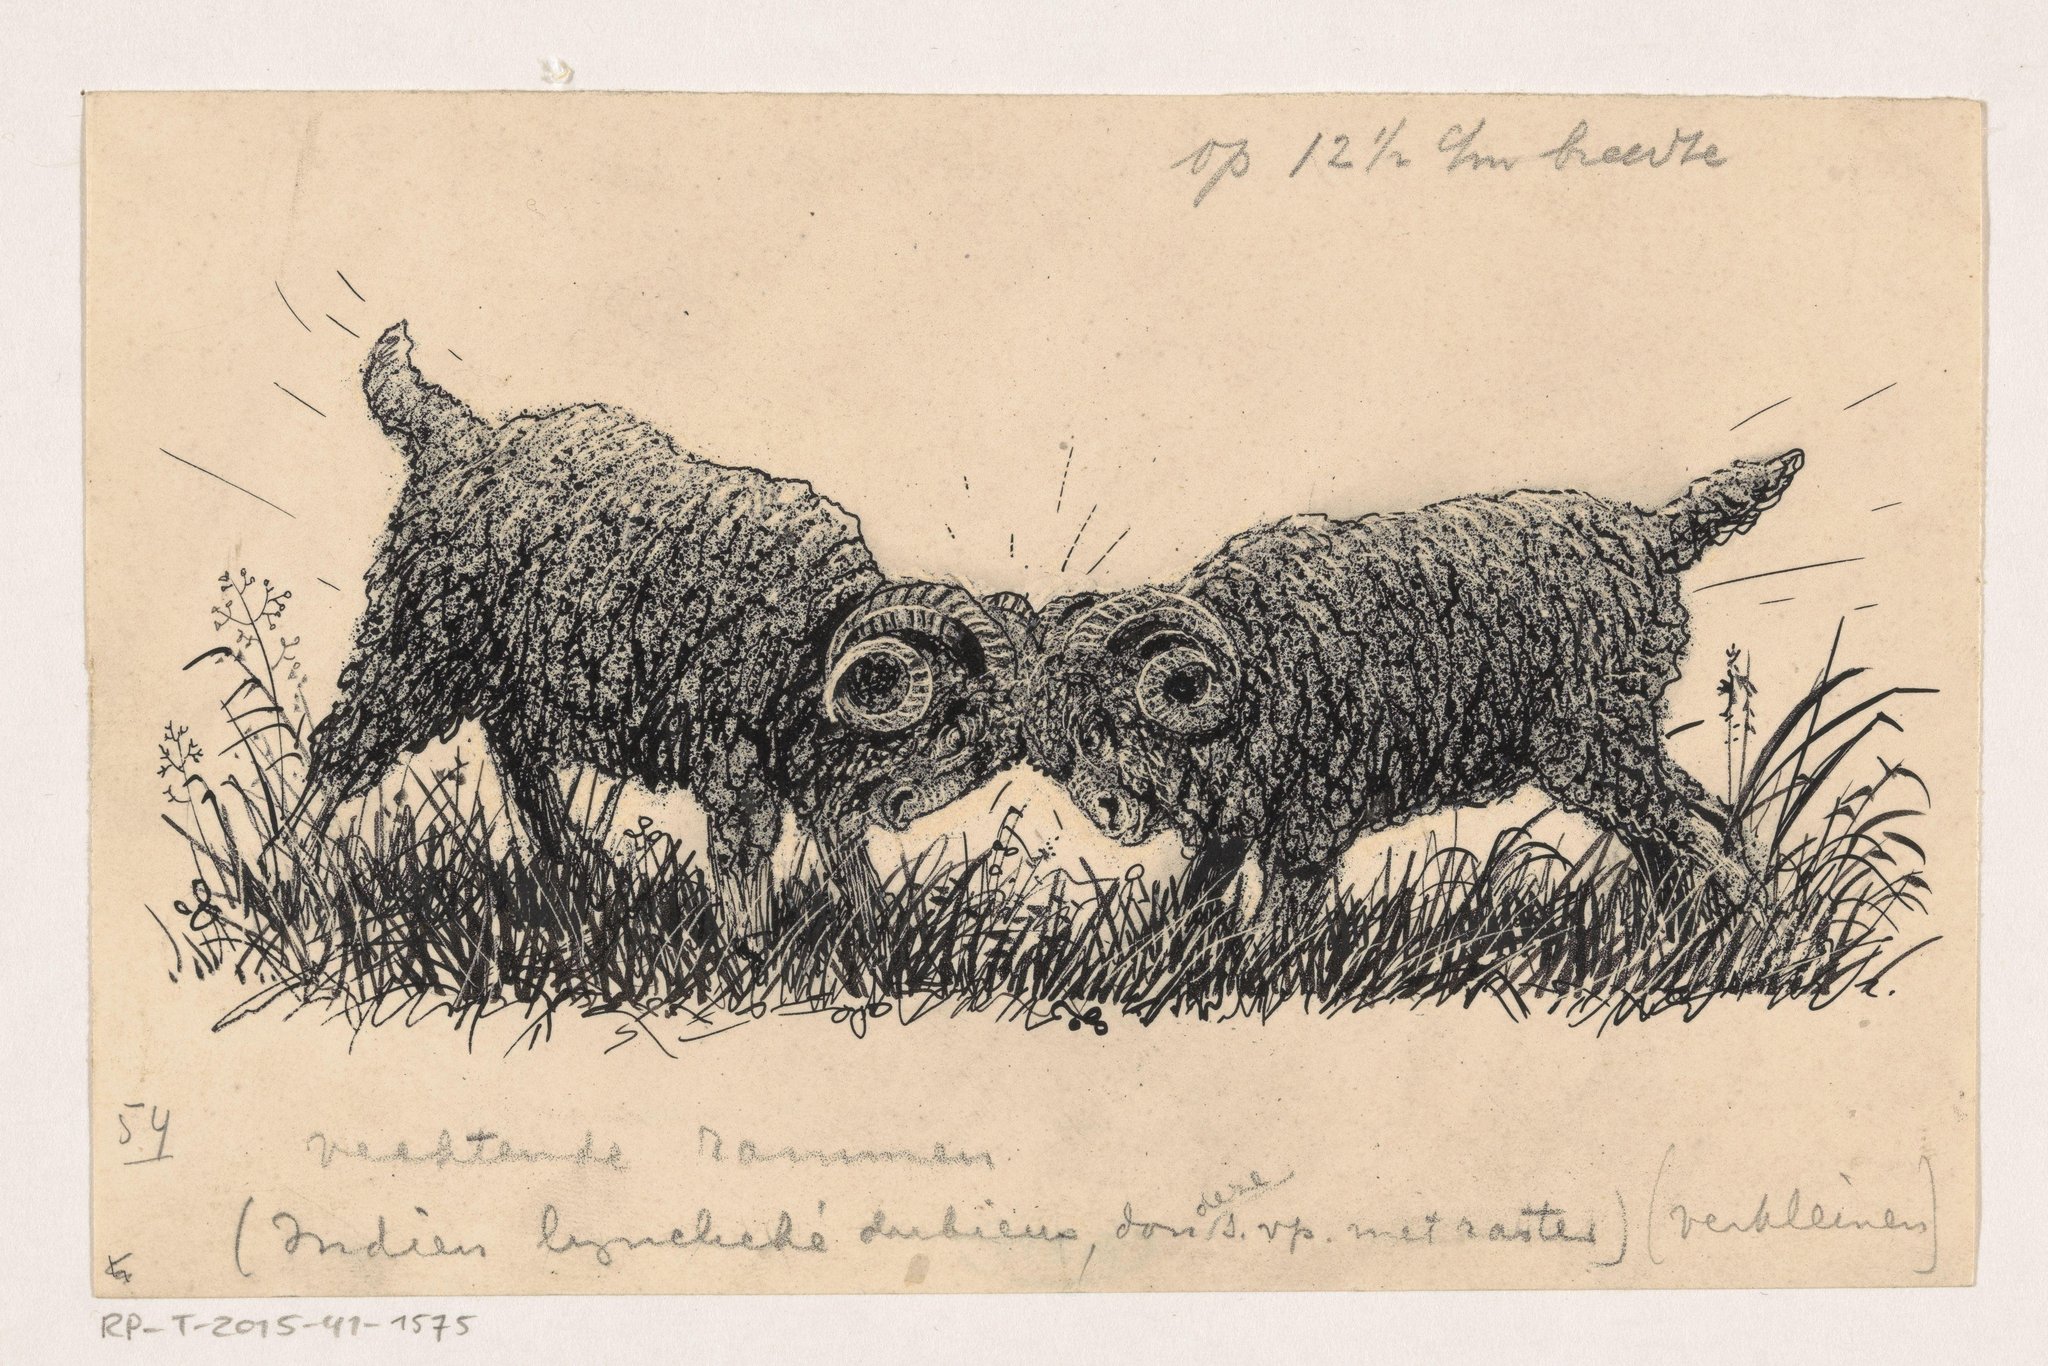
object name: boekillustratie ontwerp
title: Twee vechtende rammen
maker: henri verstijnen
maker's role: draughtsman, print maker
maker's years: 1882-1940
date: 1892-1940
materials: ink, paper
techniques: pen, spatter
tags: ram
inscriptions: :, annotation: ‘54 vechtende rammen’, collector's mark: Lugt 2228, annotation: ‘Ko[...]ing, Wintersche weide’